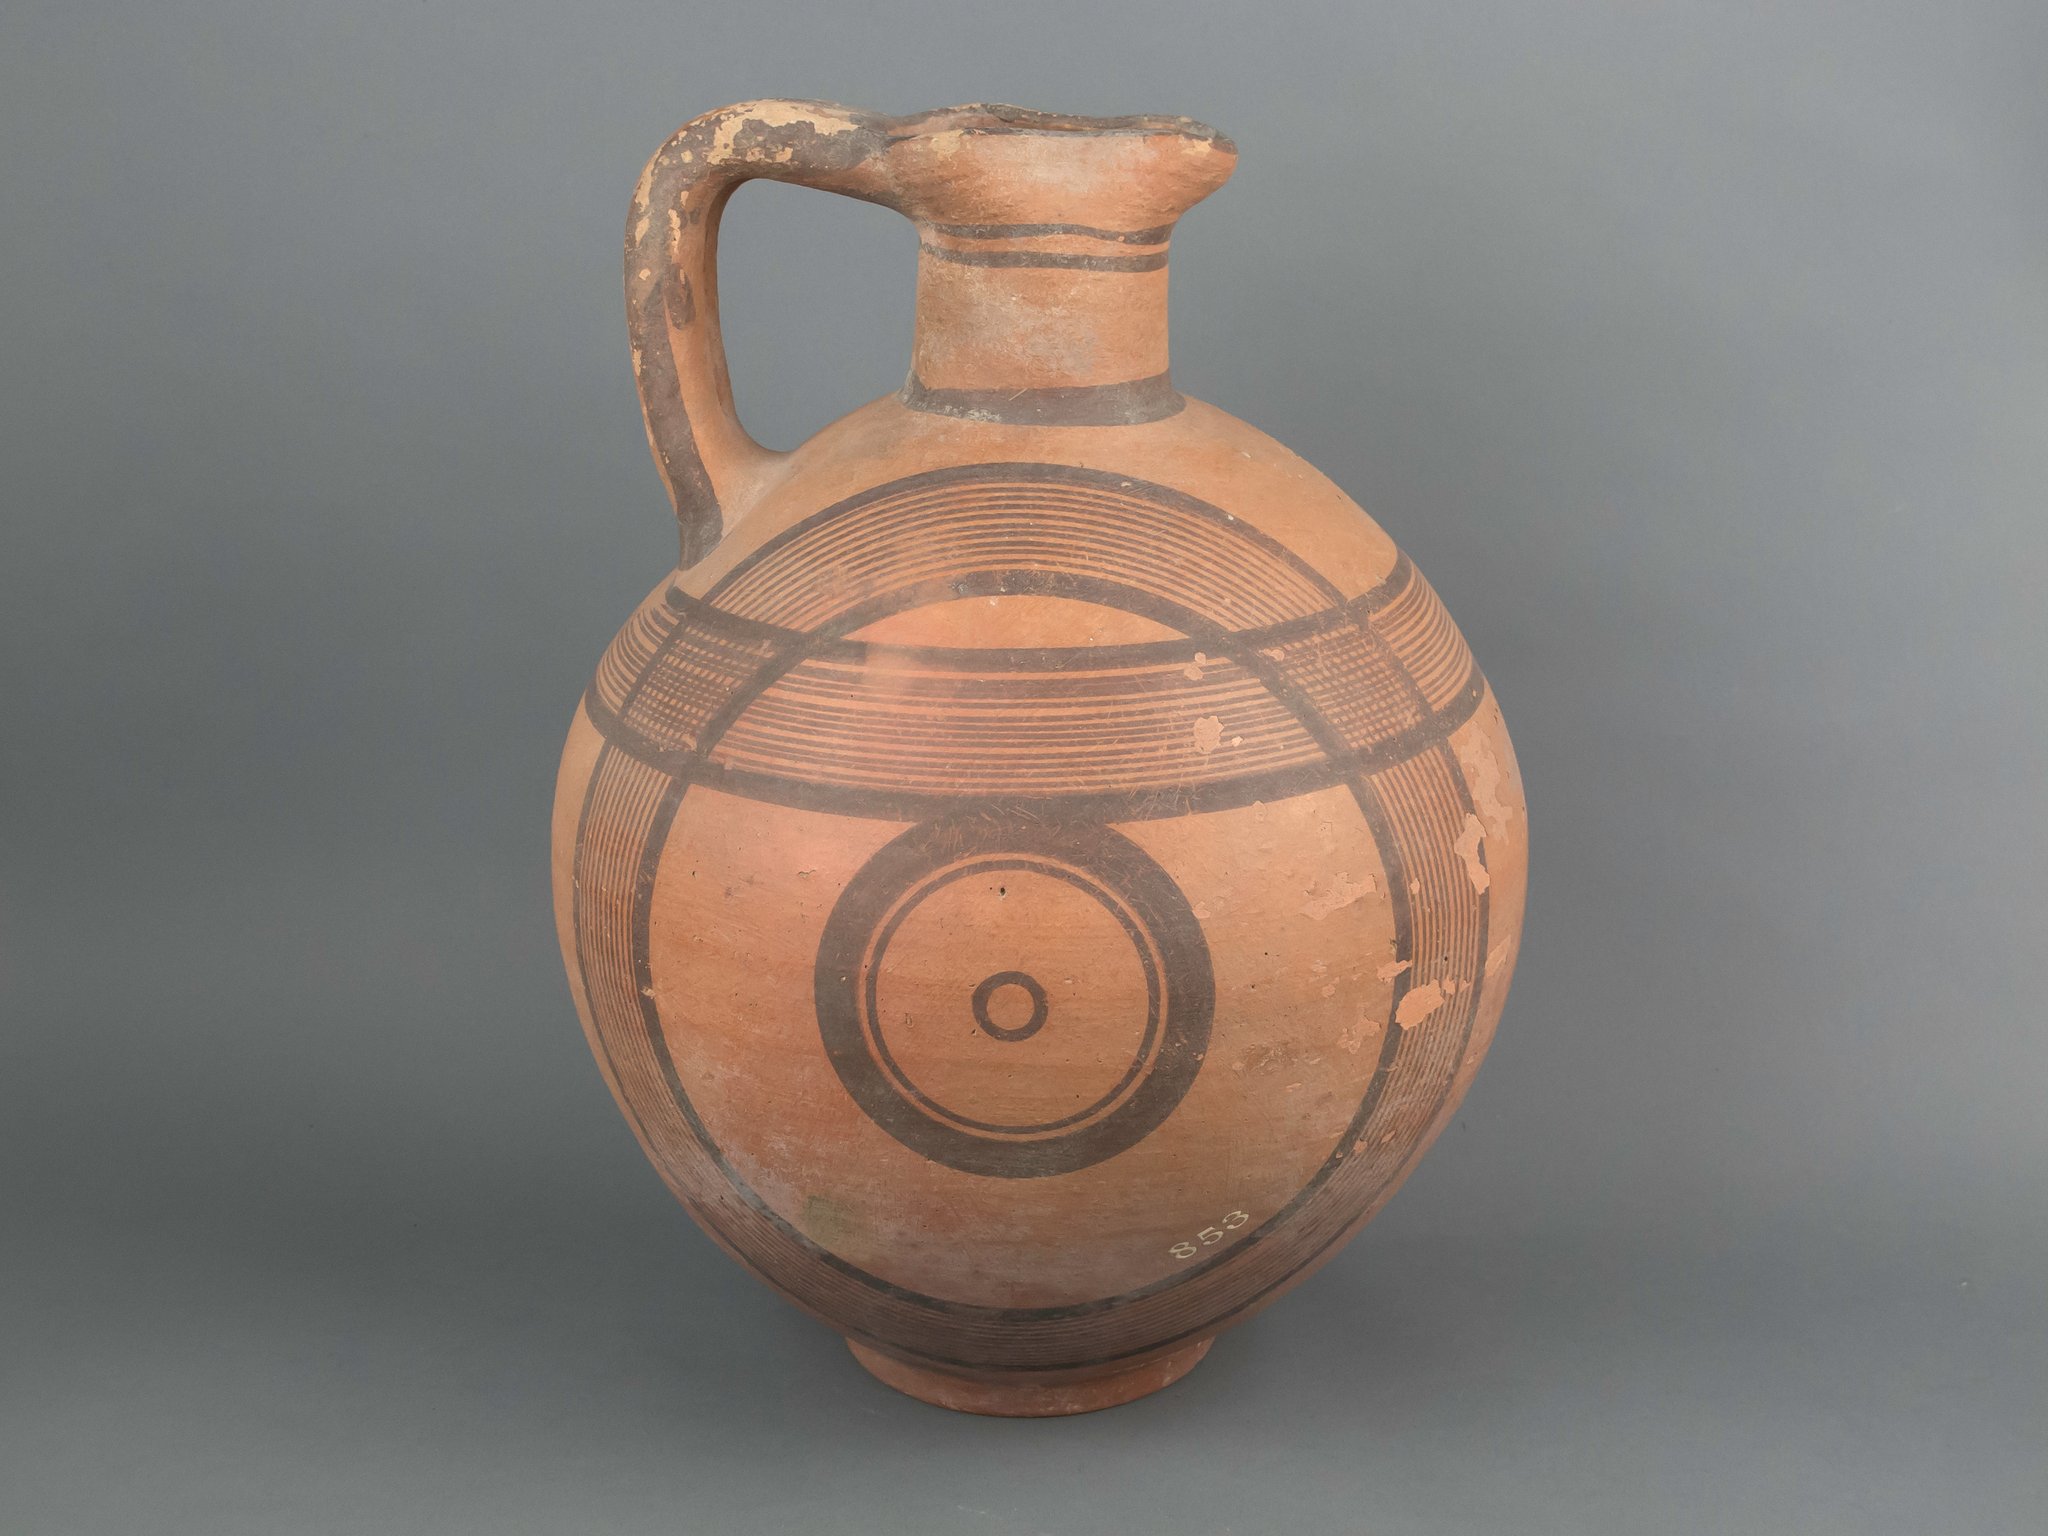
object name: jug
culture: cypriot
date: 750-600 BCE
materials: terracotta